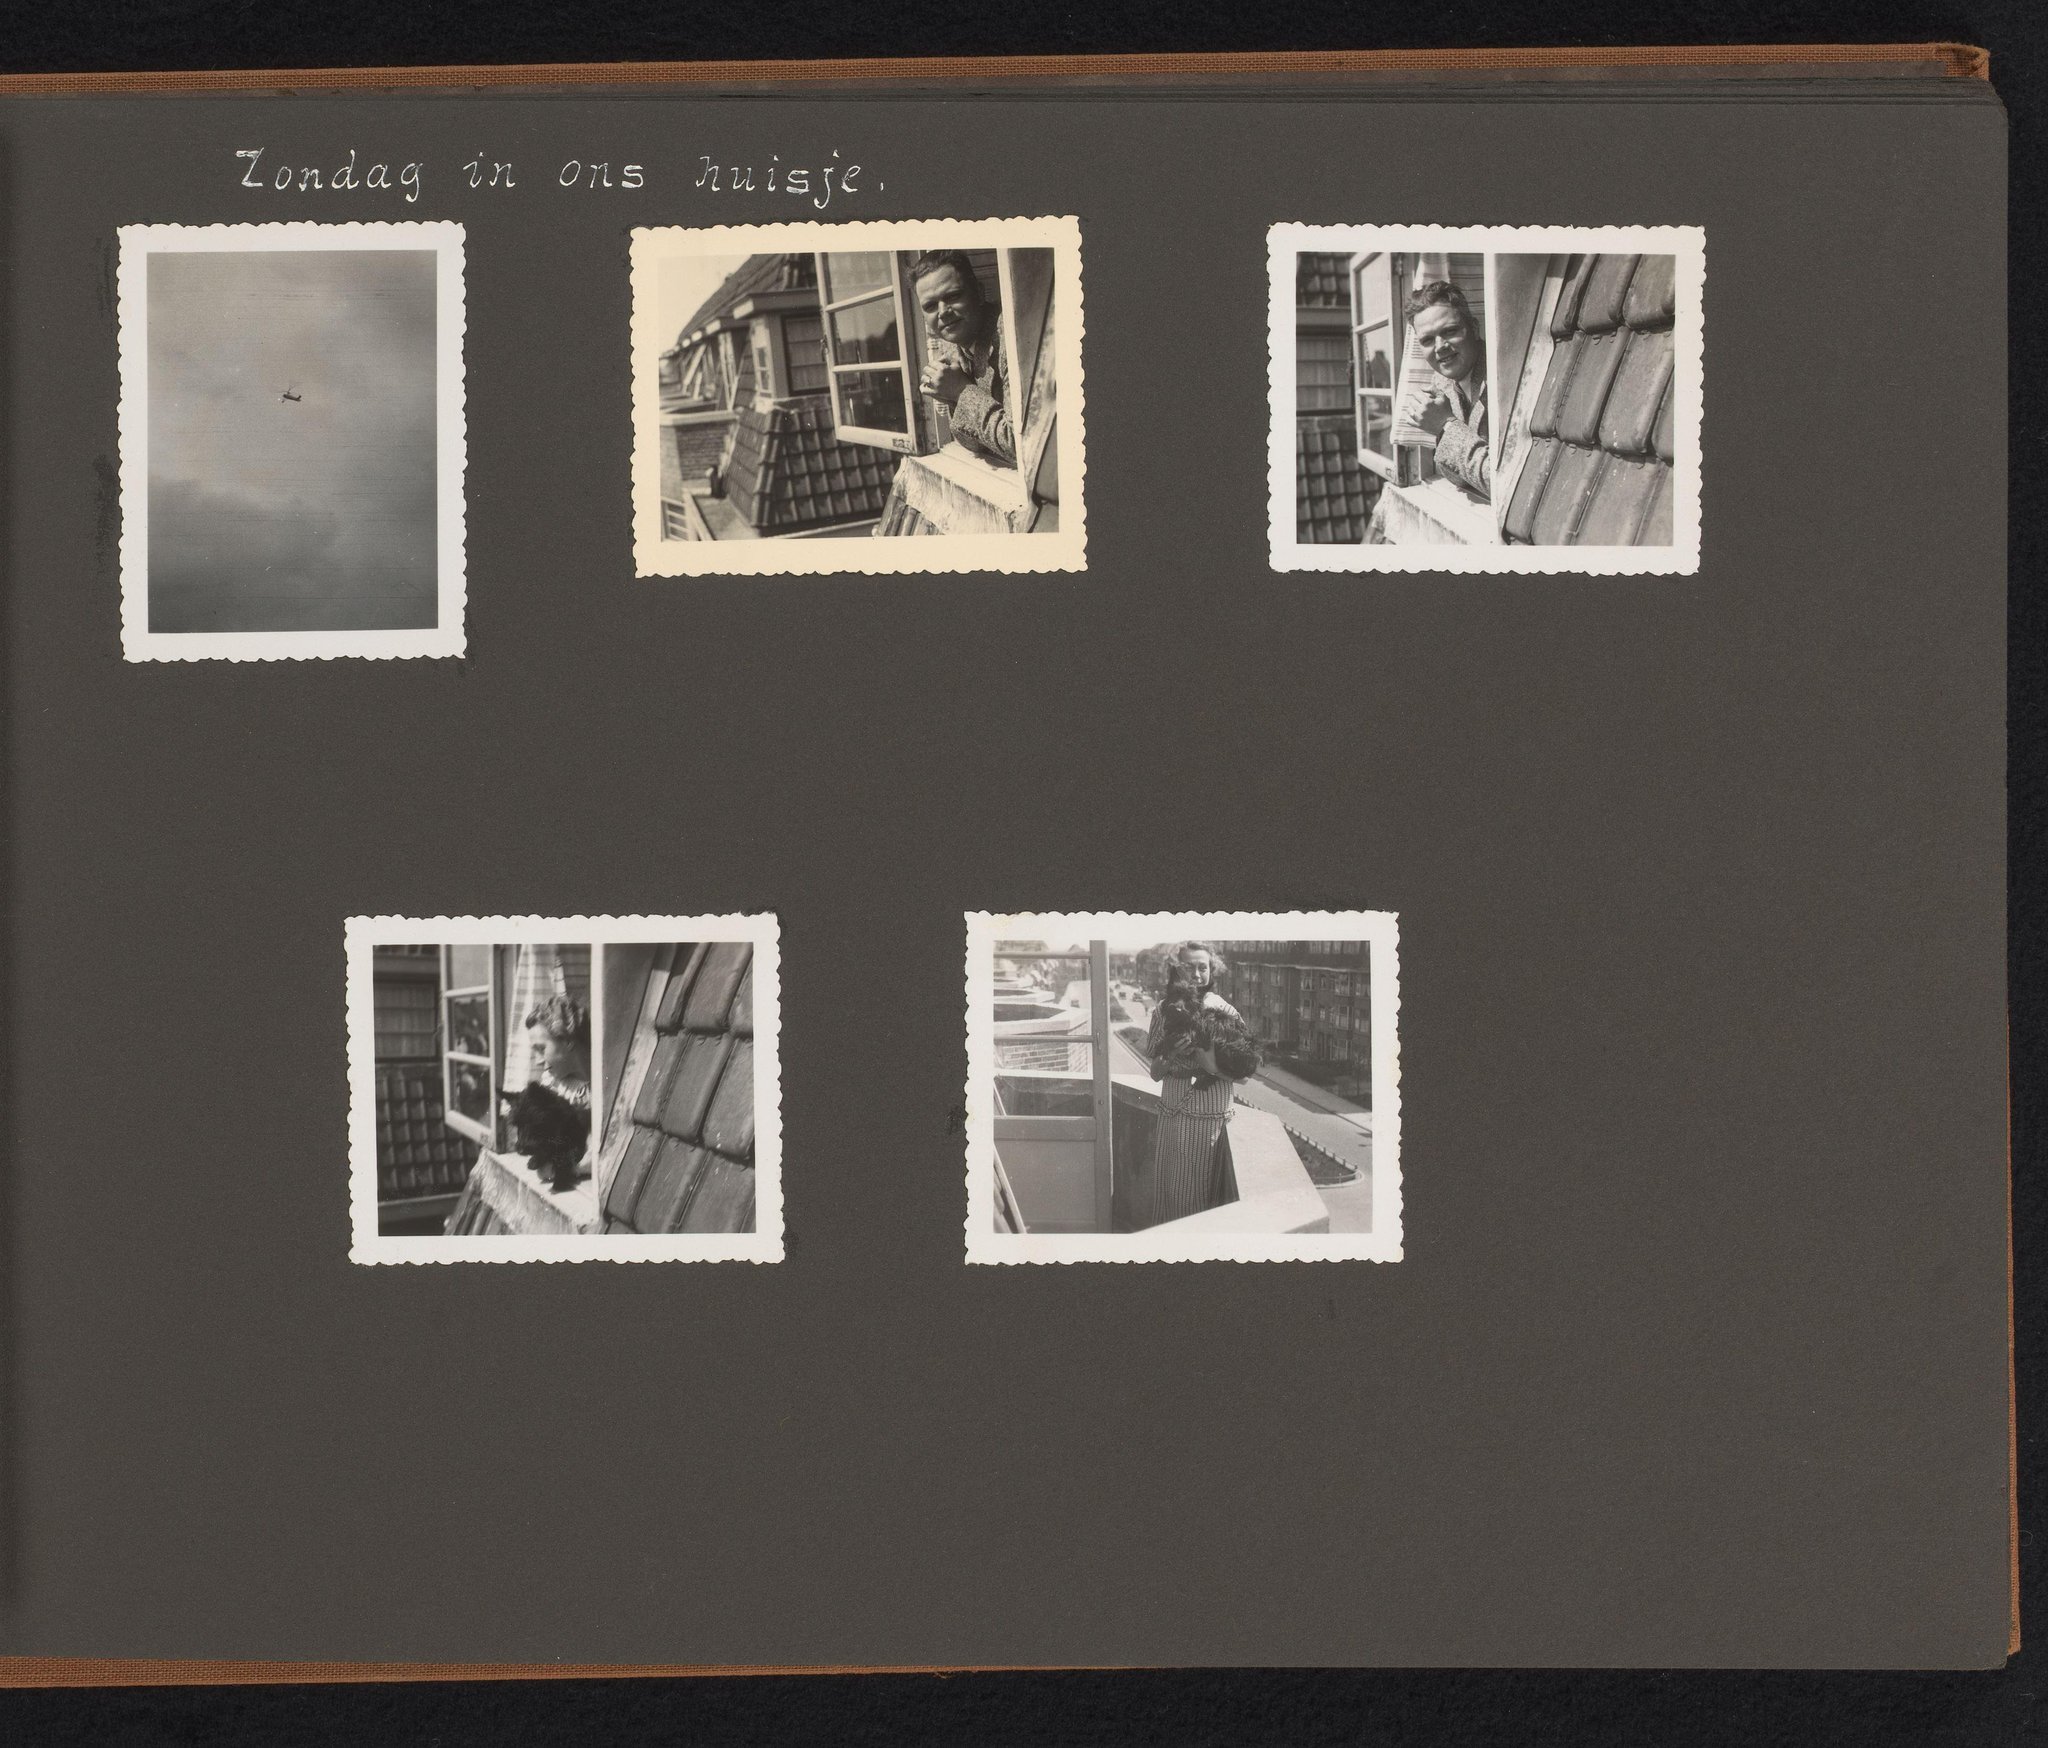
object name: album leaf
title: Echtpaar Berti Hoppe en Herman Besselaar in hun huis te Rotterdam en een overvliegende helikopter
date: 1905-1936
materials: cardboard, paper, photographic support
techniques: gelatin silver print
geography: rotterdam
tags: herman besselaar, berti hoppe, urban housing, historical persons - bb - woman, helicopter, historical persons, rotterdam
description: Vijf foto's gemaakt op een zondag in 1936. Deze pagina maakt deel uit van een album.